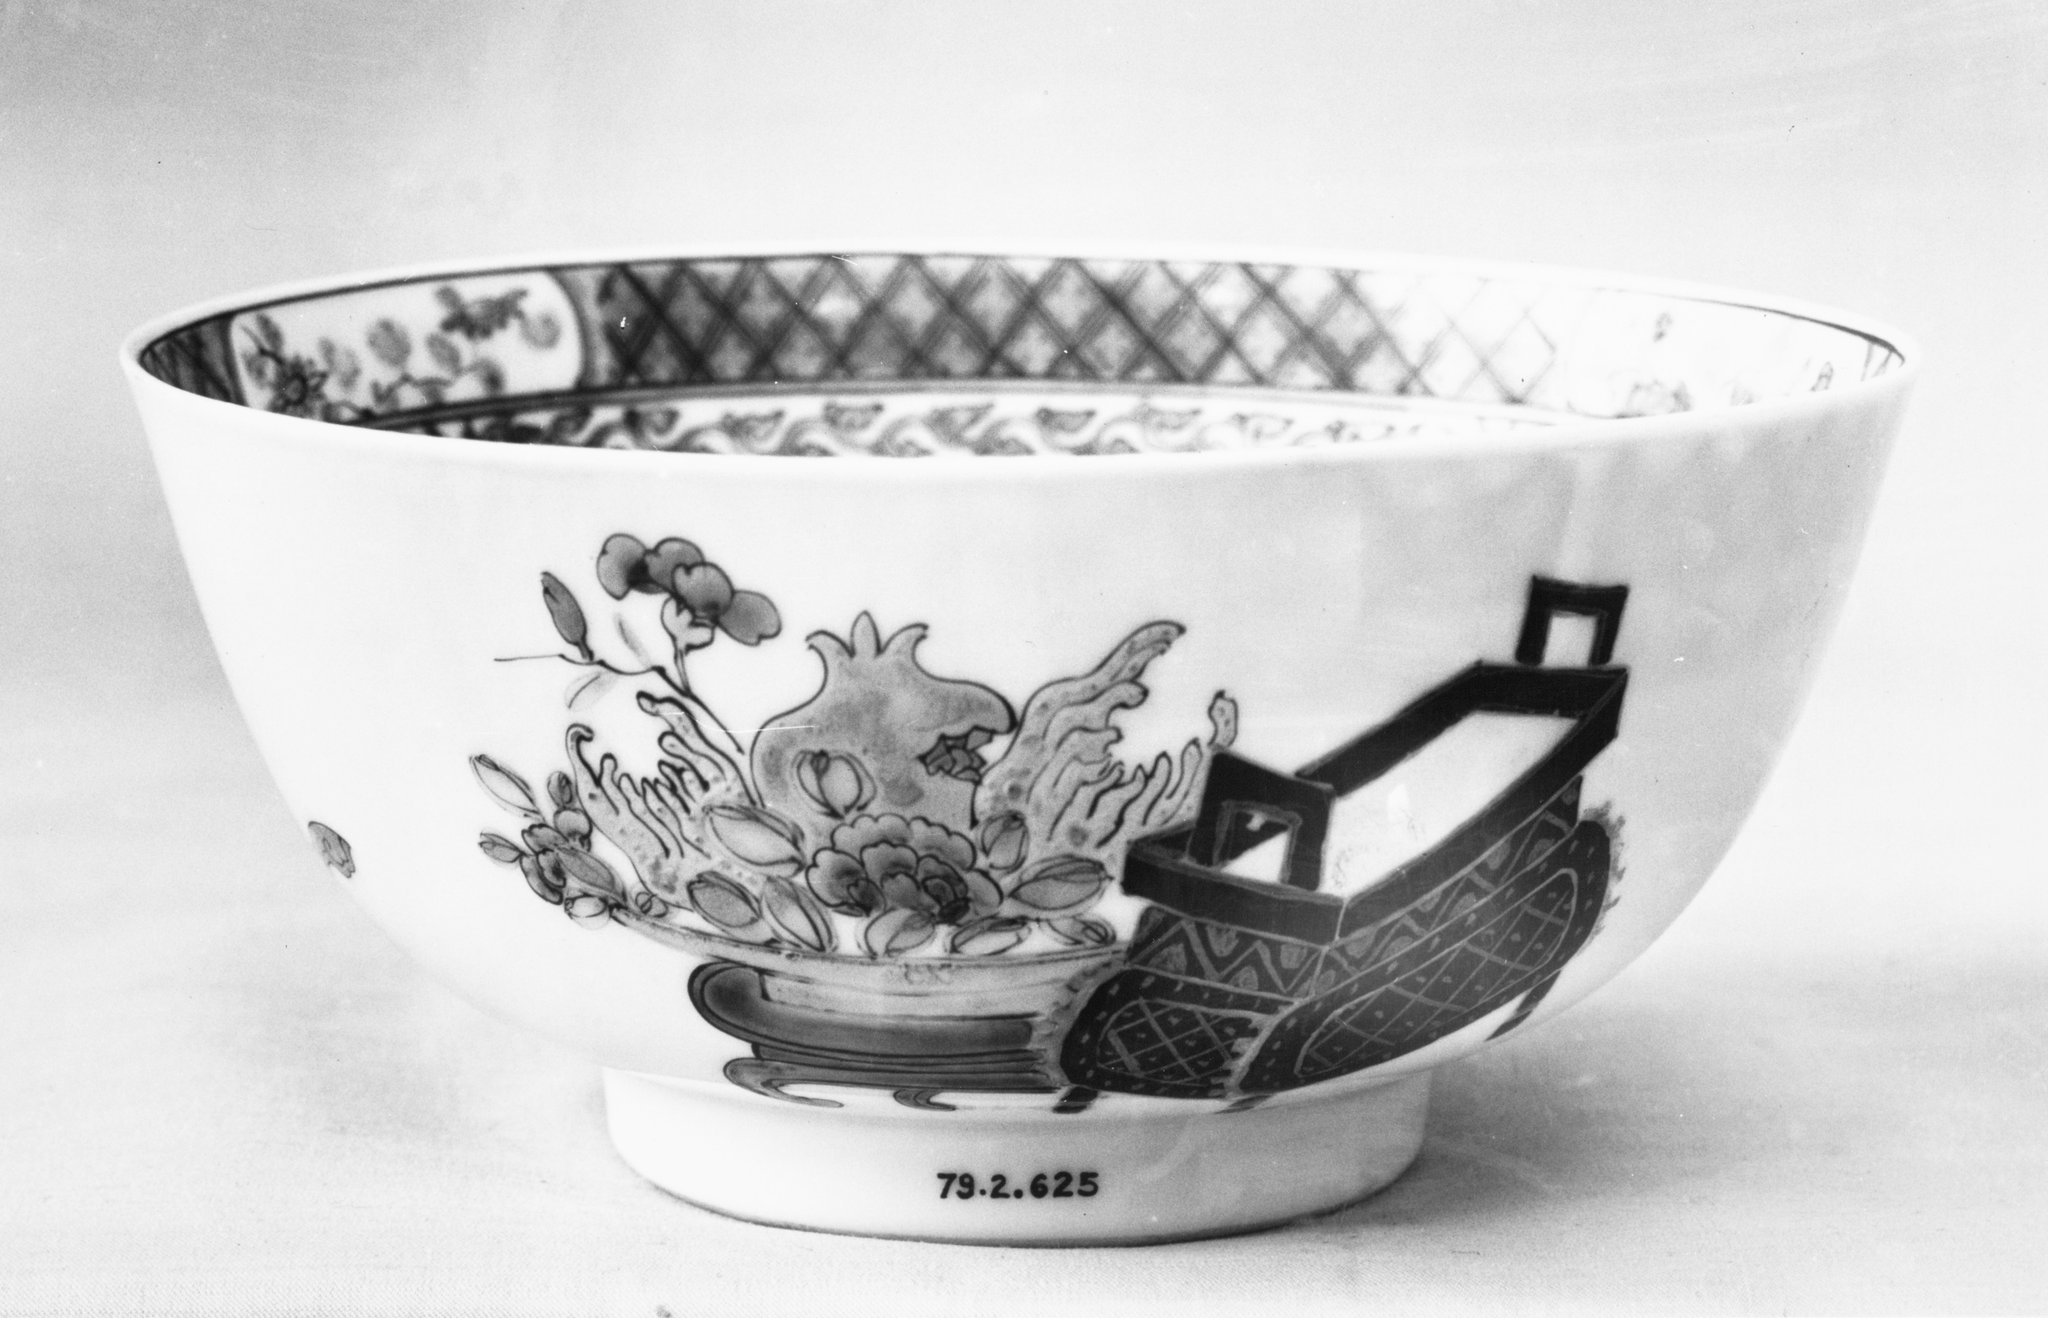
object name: bowl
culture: chinese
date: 1730-1750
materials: enamel, porcelain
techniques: overglaze, painting